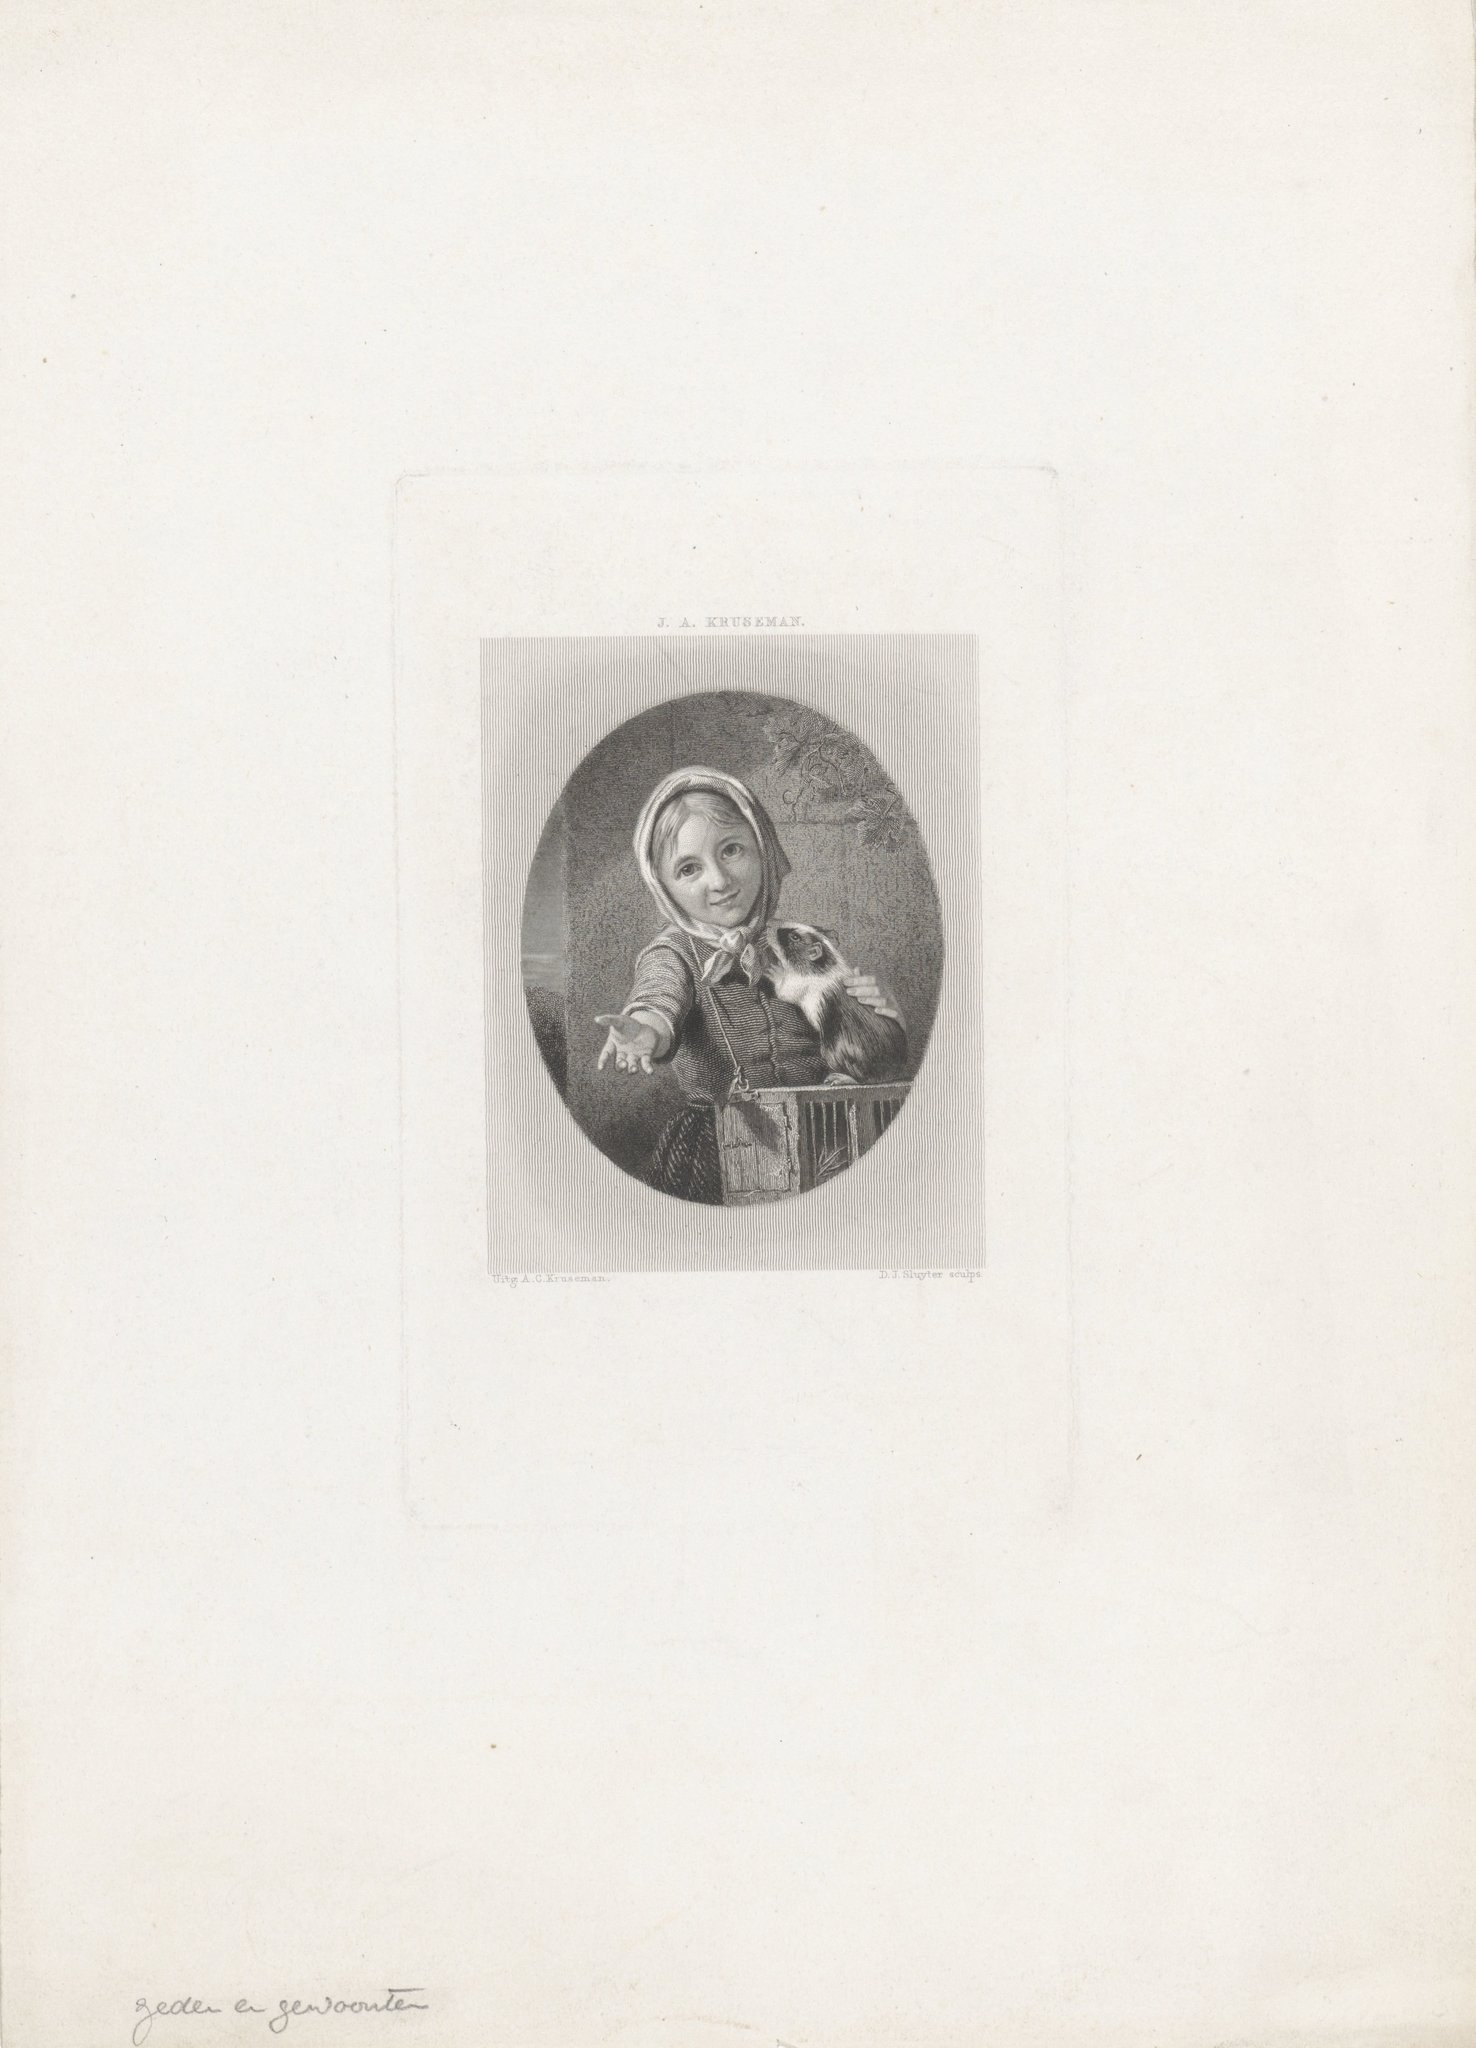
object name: print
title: Meisje met cavia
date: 1855-1864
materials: paper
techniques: etching, roulette, engraving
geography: haarlem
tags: earning money with guinea-pig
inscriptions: collector's mark: Lugt 2233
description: Een meisje met hoofddoekje houdt haar hand op met een vragende blik in haar ogen. Met de andere hand houdt ze een een cavia vast. De cavia zit boven op een kooi, die het meisje met een touw om haar nek draagt.